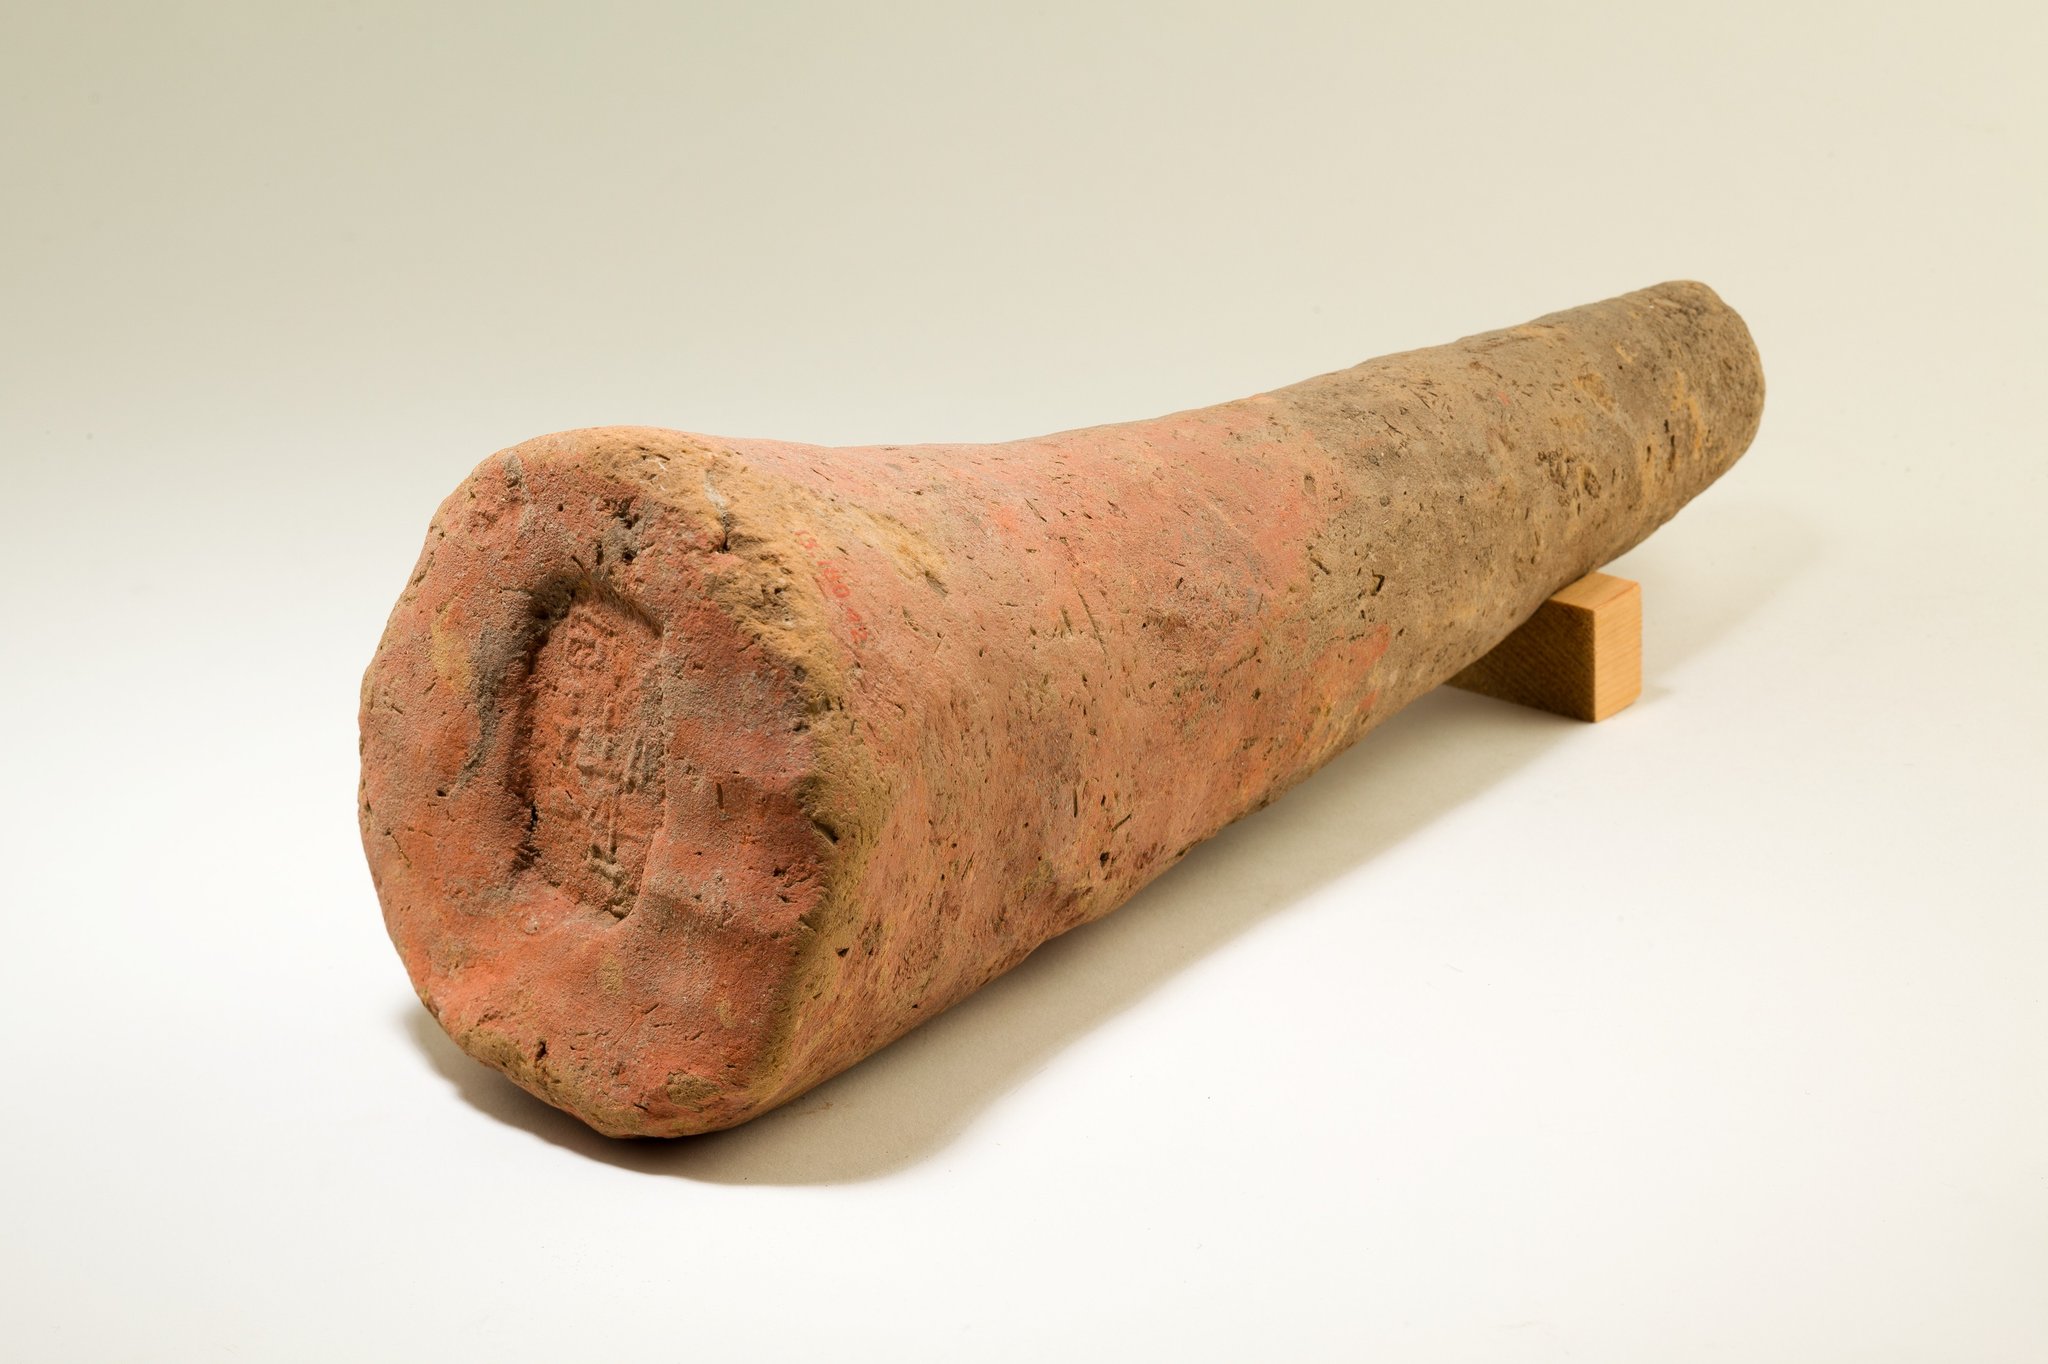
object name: cone, oval impression, abekh, steward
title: Funerary Cone of the Steward Abekh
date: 1550-1295 BCE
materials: pottery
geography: egypt